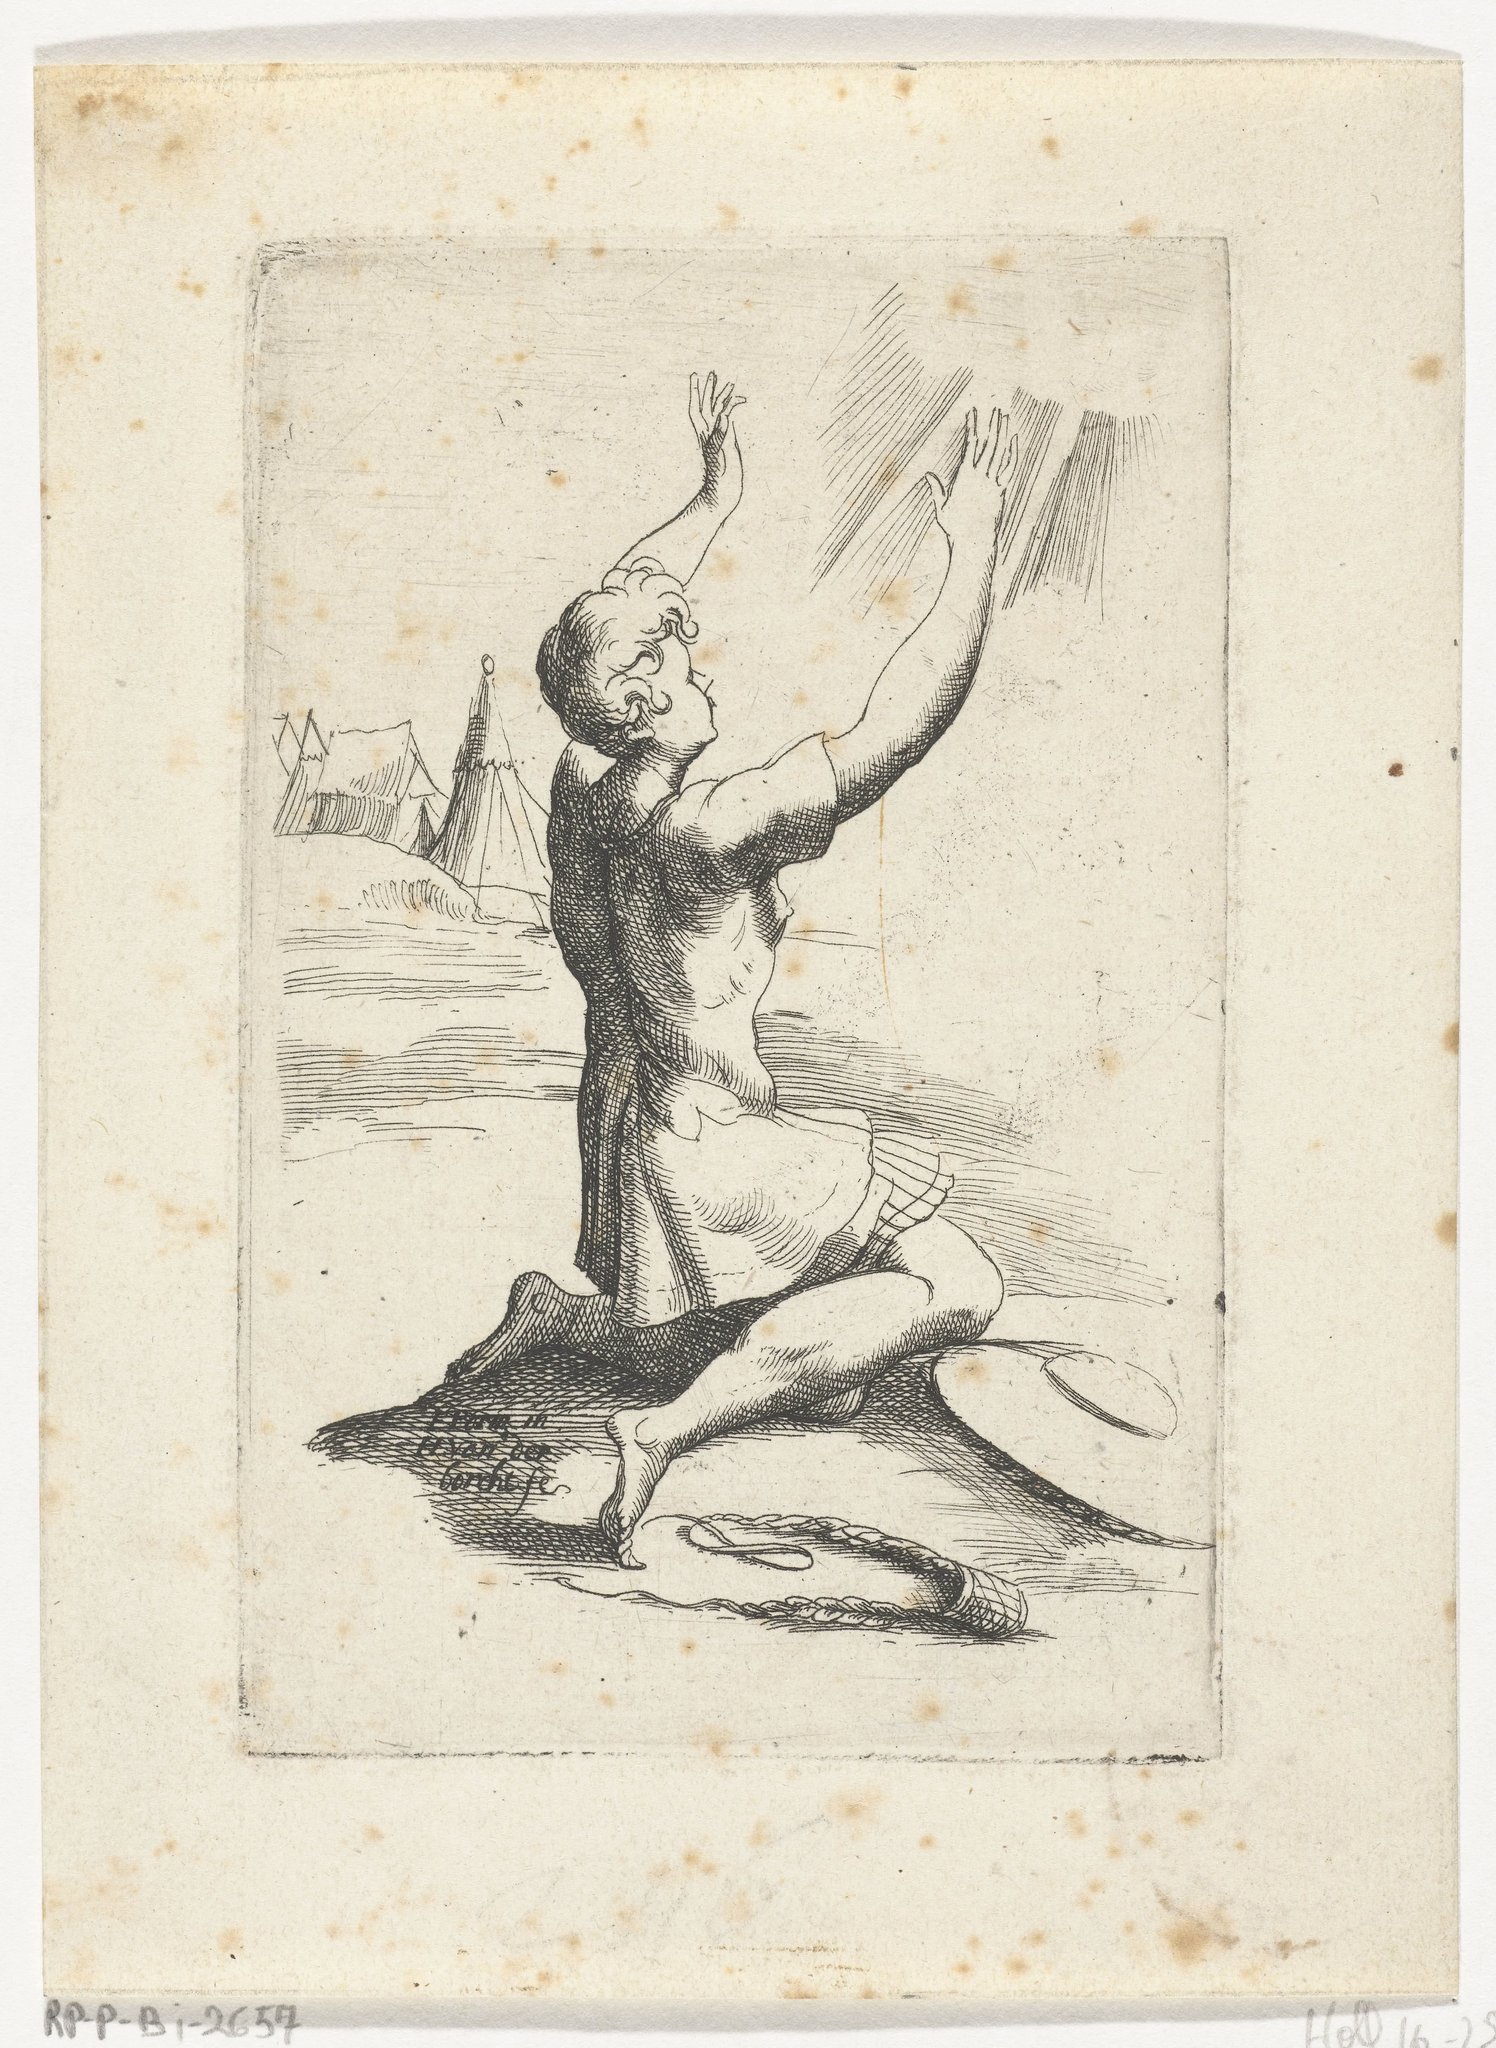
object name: print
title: Libreto di diversi figurine dissignato da Fran. parmensis et conservata nella Collezione Arondelyna, 1638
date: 1638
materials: paper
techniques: etching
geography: italy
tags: casting weapons: sling, david thanks the lord after he has slain the giant goliath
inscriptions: collector's mark: Lugt 240 of 1838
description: David knielt naar rechts en heft beide armen de hemel in. In de rechterhoek dalen stralen uit de hemel. Naast hem liggen slinger en schild. Achter hem de contouren van het Israëlisch legerkamp. David heeft waarschijnlijk juist Goliath verslagen en dankt nu God voor diens bescherming (1 Samuel 17: 41-51). Prent uit een serie naar diverse tekeningen van Parmigianino uit de collectie Arundel.